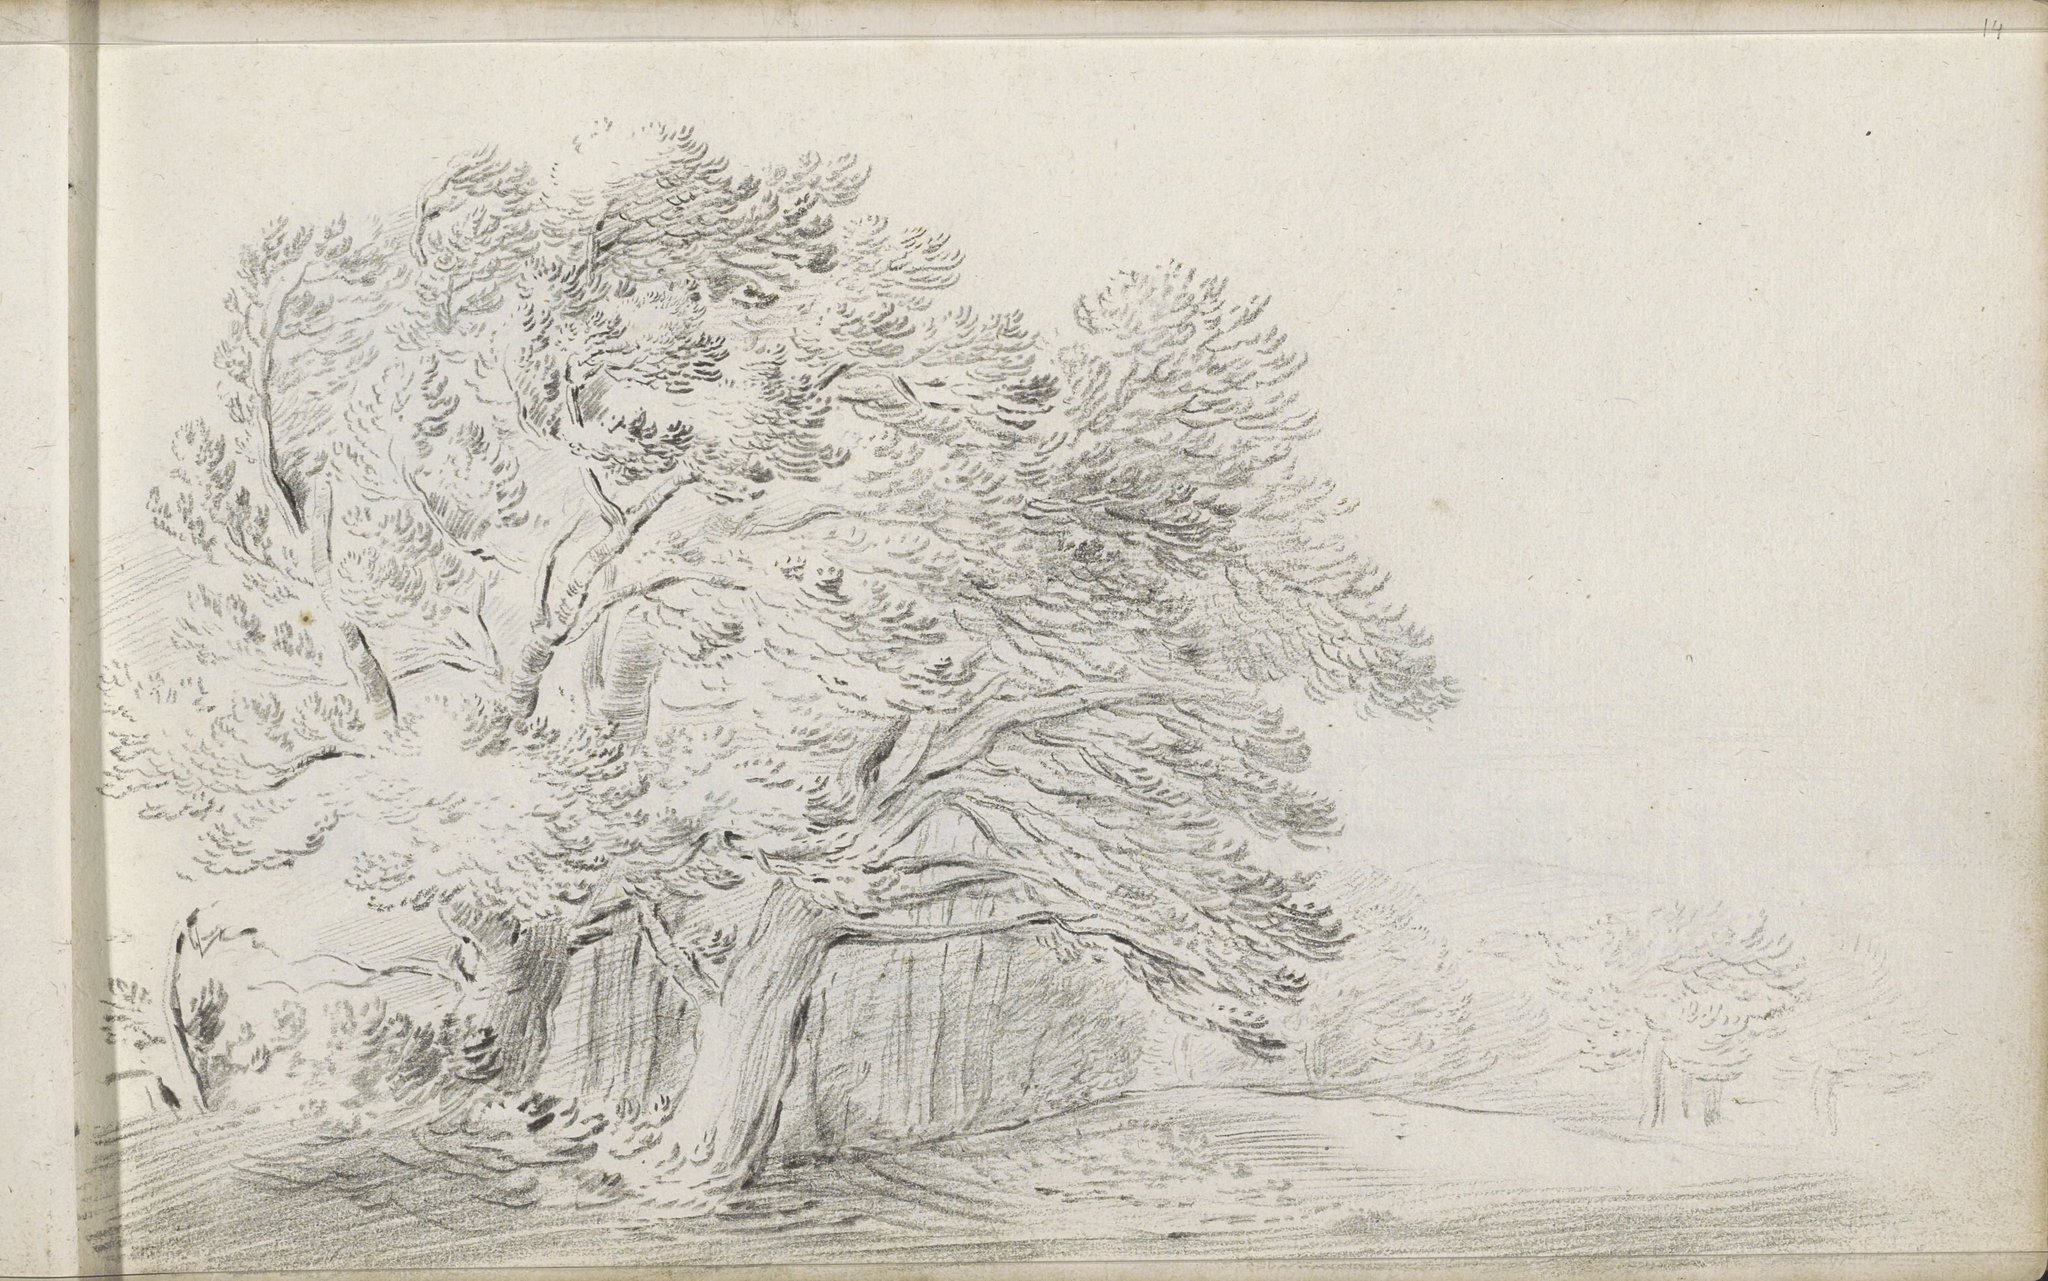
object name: sketchbook leaf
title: Landschap met bomengroep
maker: pieter moninckx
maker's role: draughtsman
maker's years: 1606-1686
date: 1645-1646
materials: chalk, paper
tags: groups of trees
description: Blad 14 recto uit een schetsboek met 39 bladen.